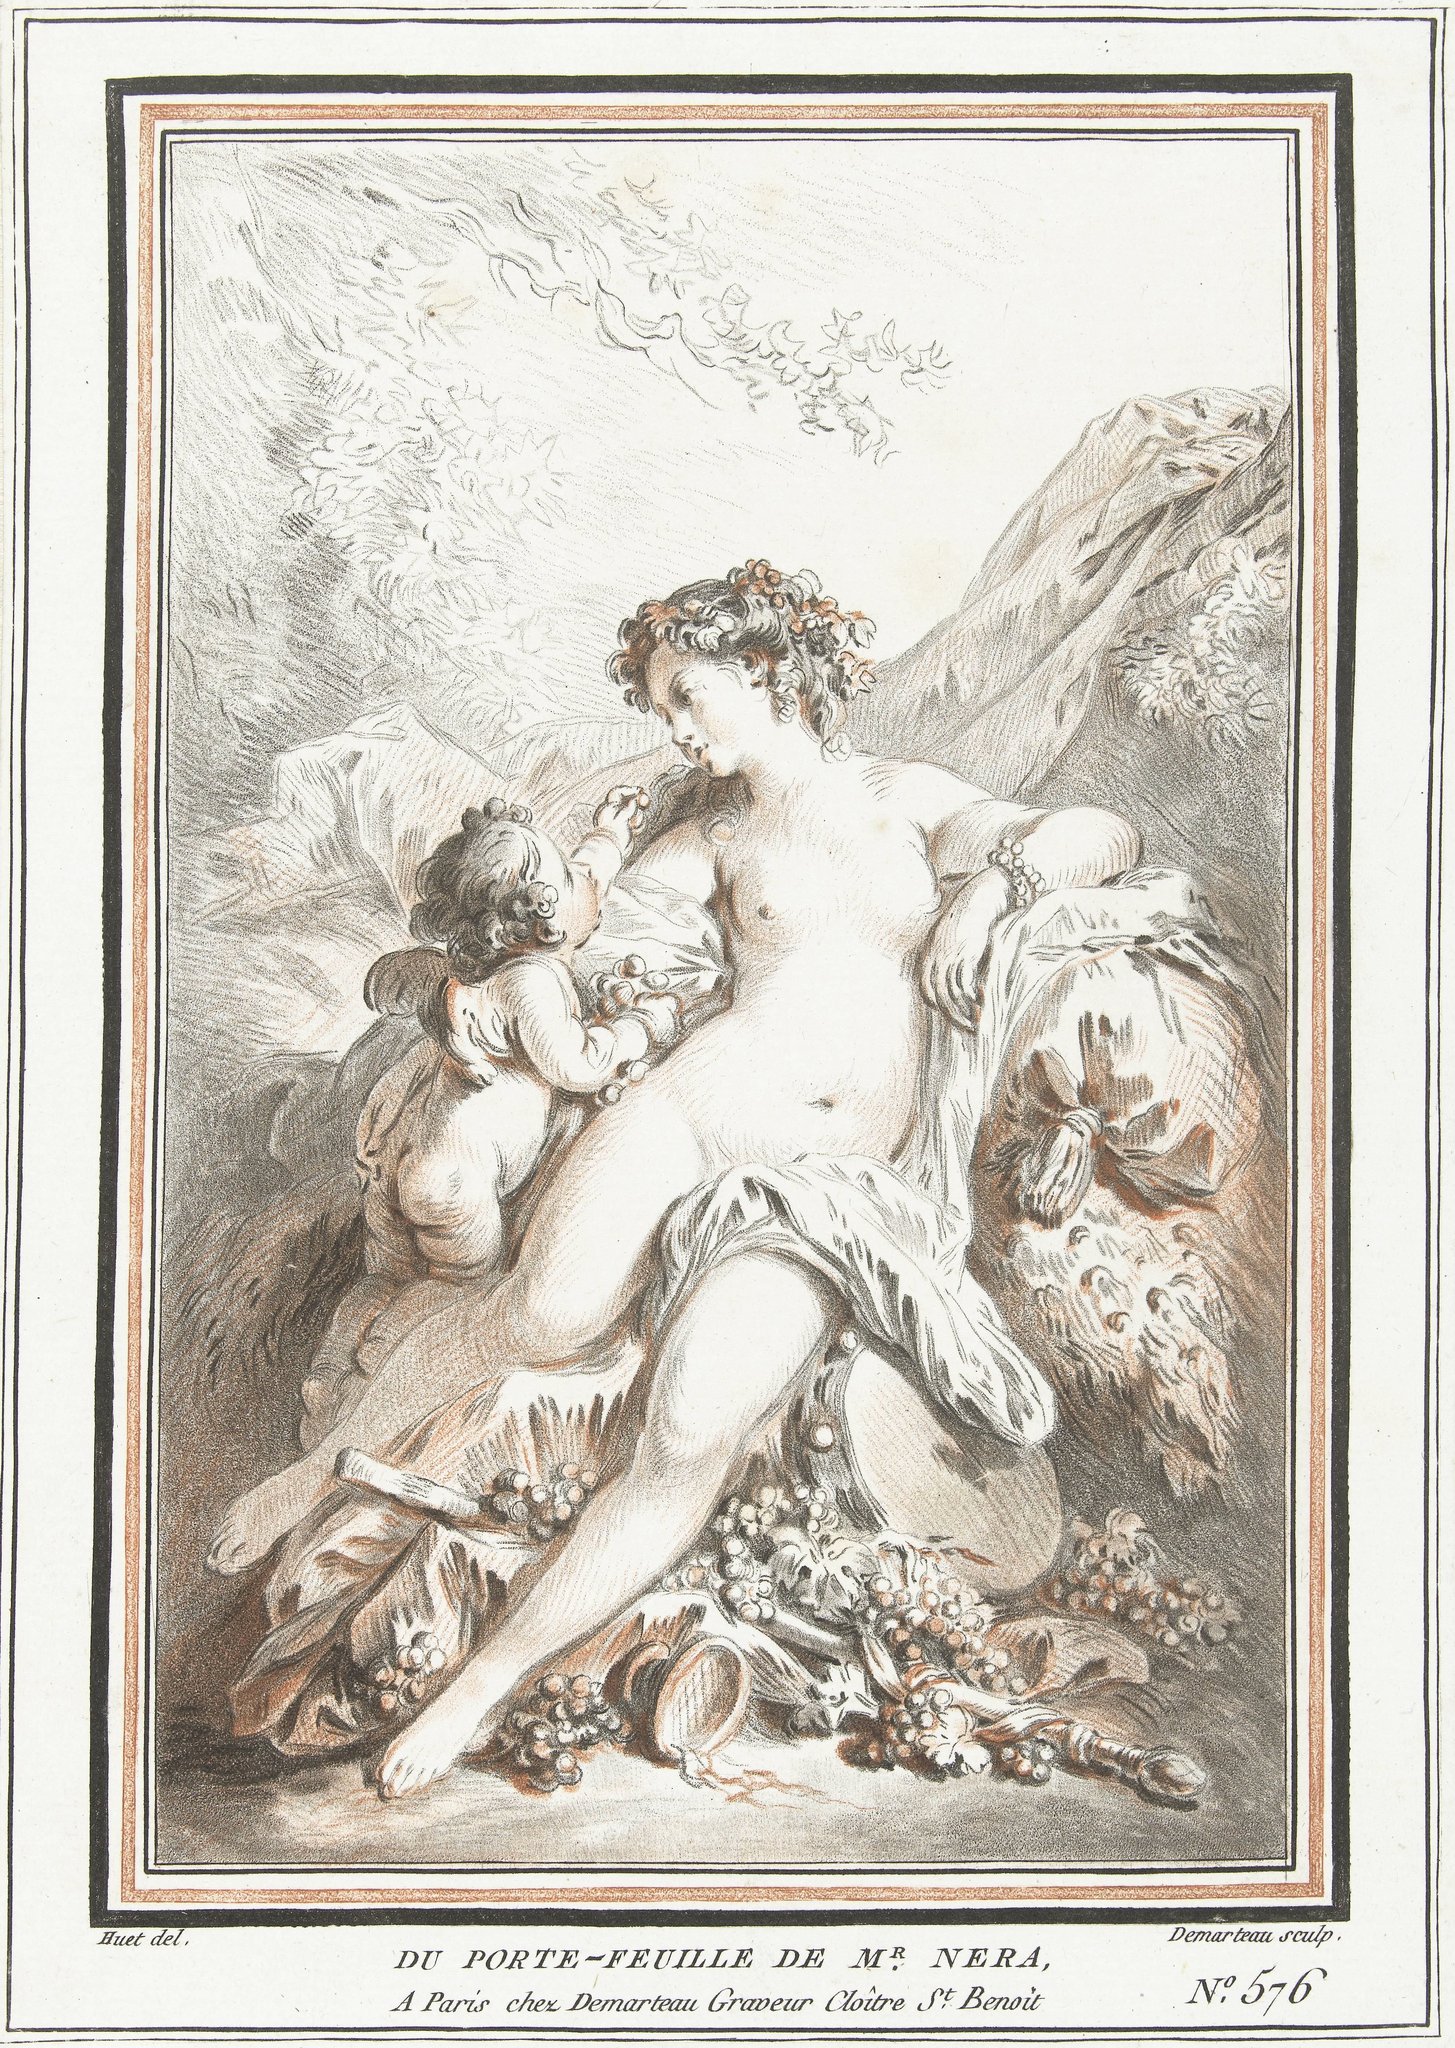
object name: print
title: Venus en Amor met druiventros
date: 1732-1776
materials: paper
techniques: printmaking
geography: paris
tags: bunch of grapes, venus and cupid (cupid not being mere attribute)